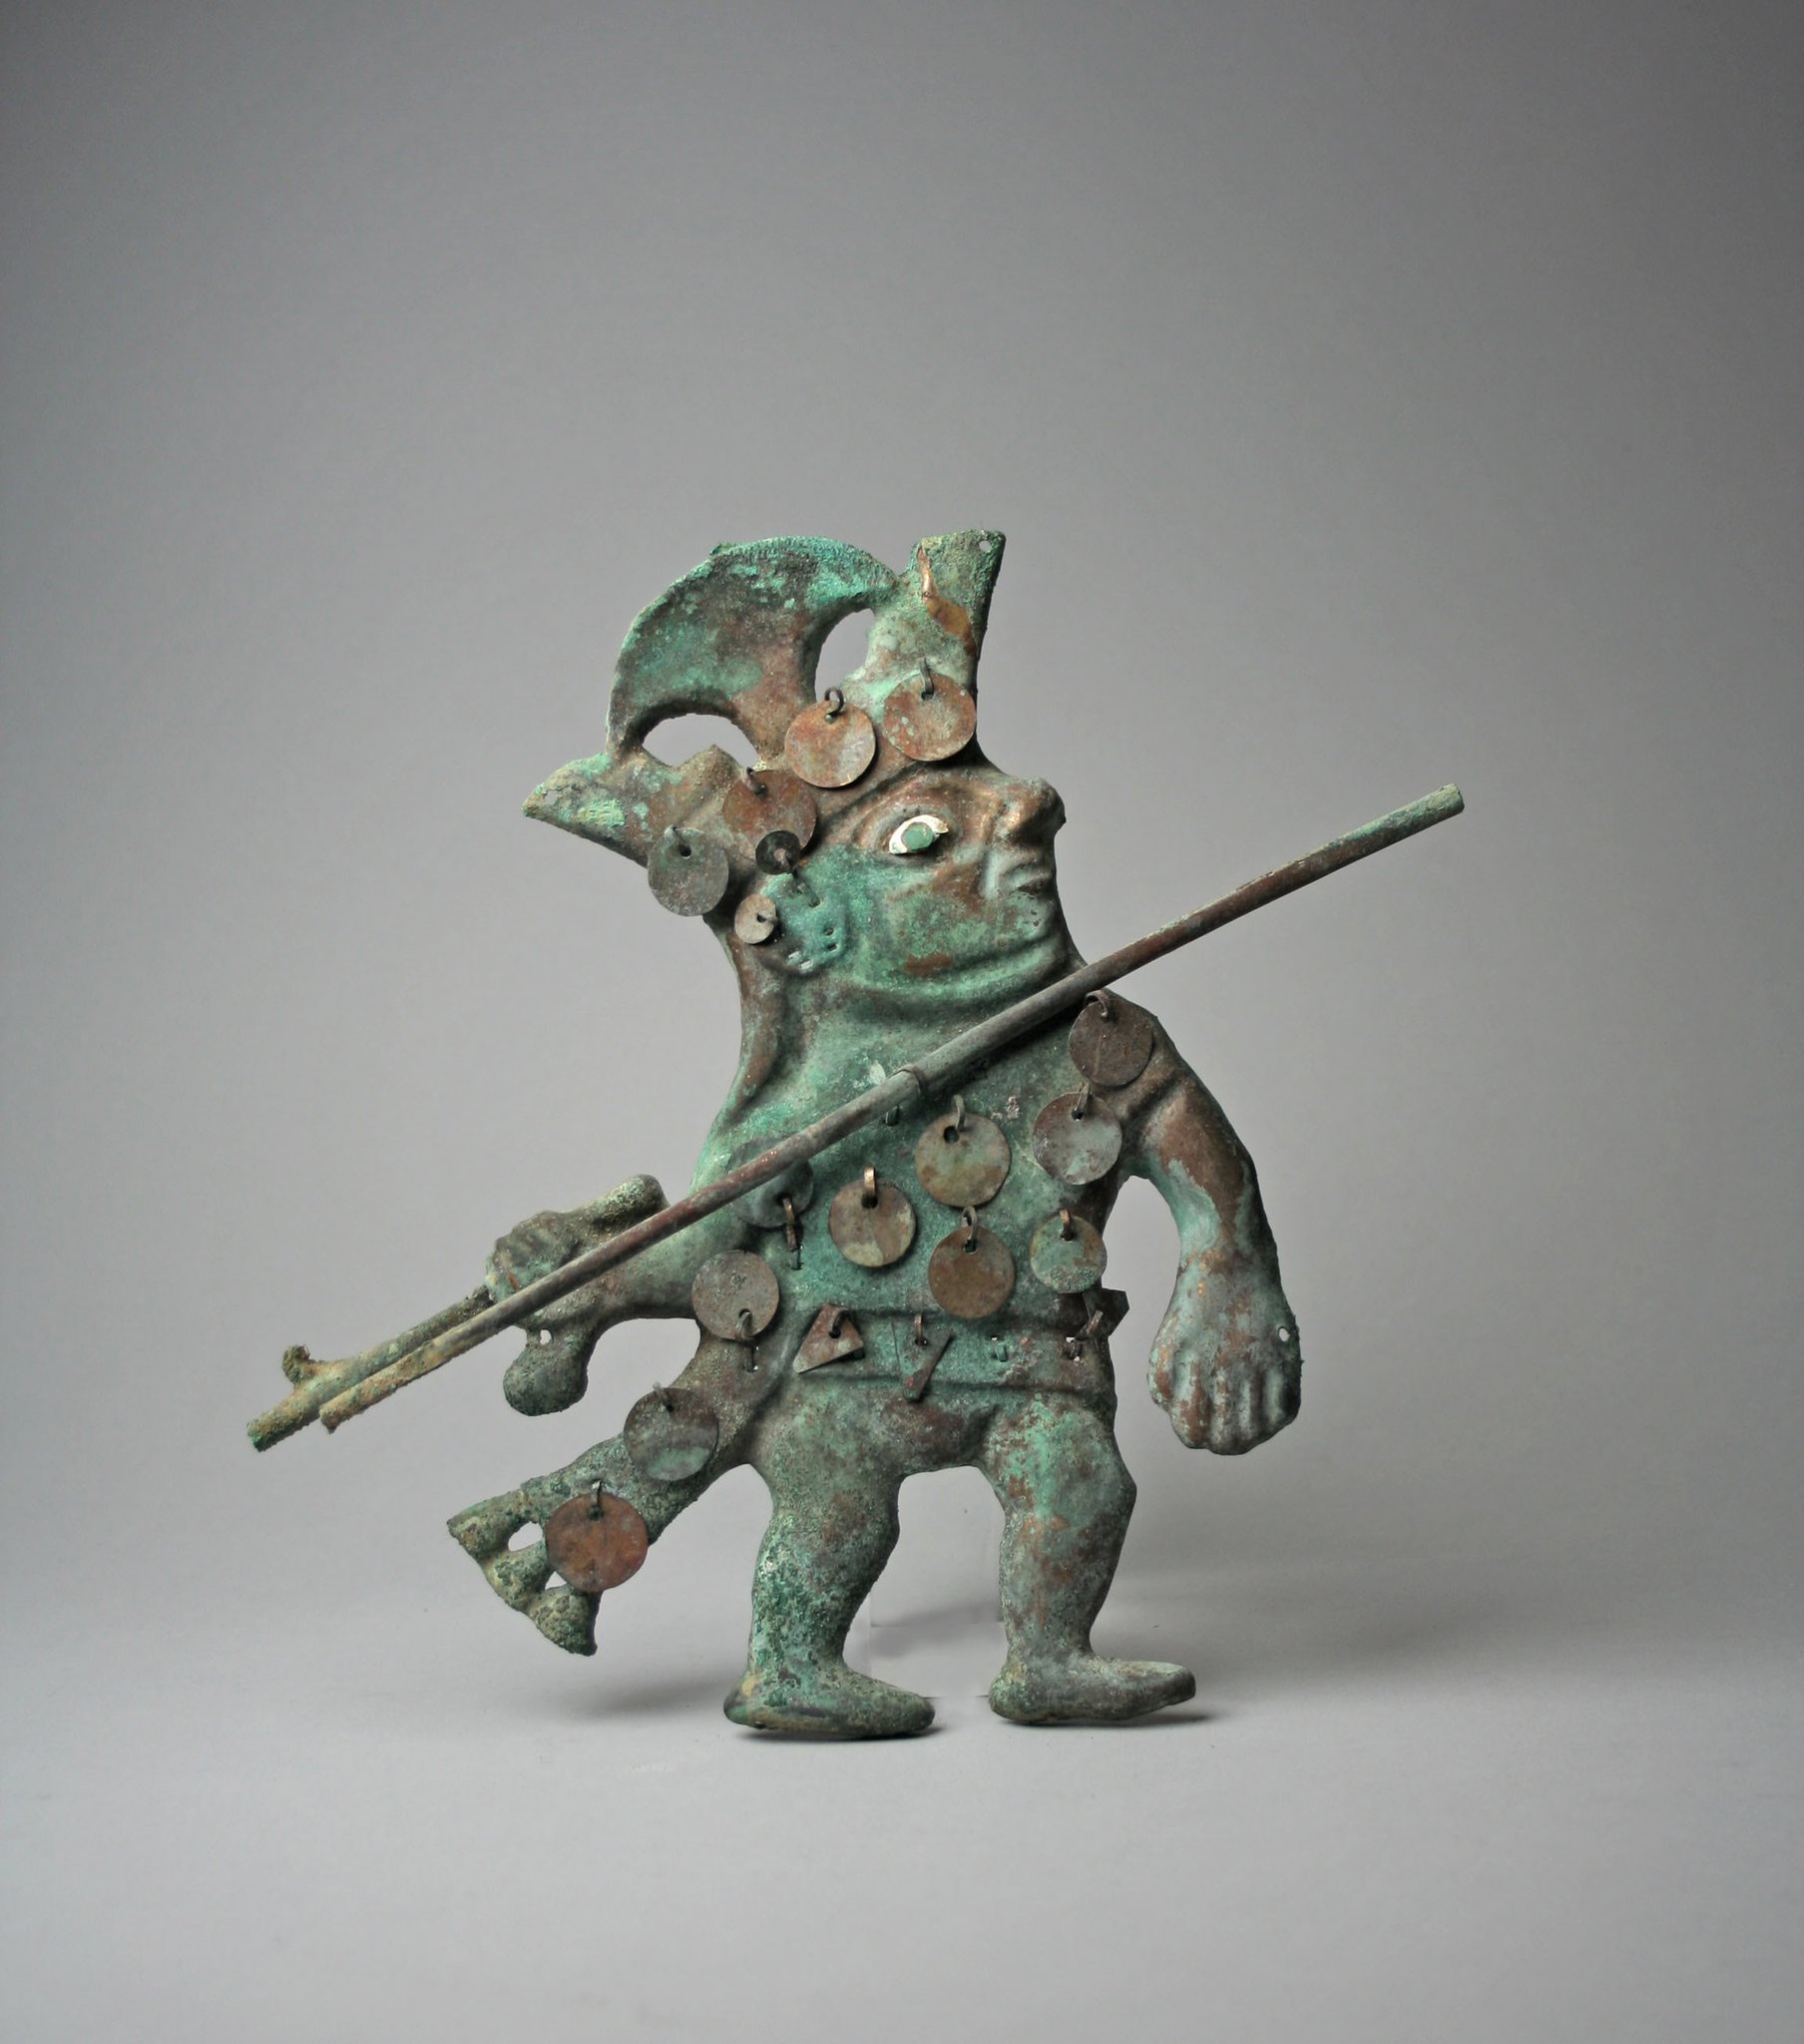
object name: ornament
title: Profile Warrior Ornament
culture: moche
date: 501-700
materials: gilt copper, shell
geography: peru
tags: human figures,weapons,profiles